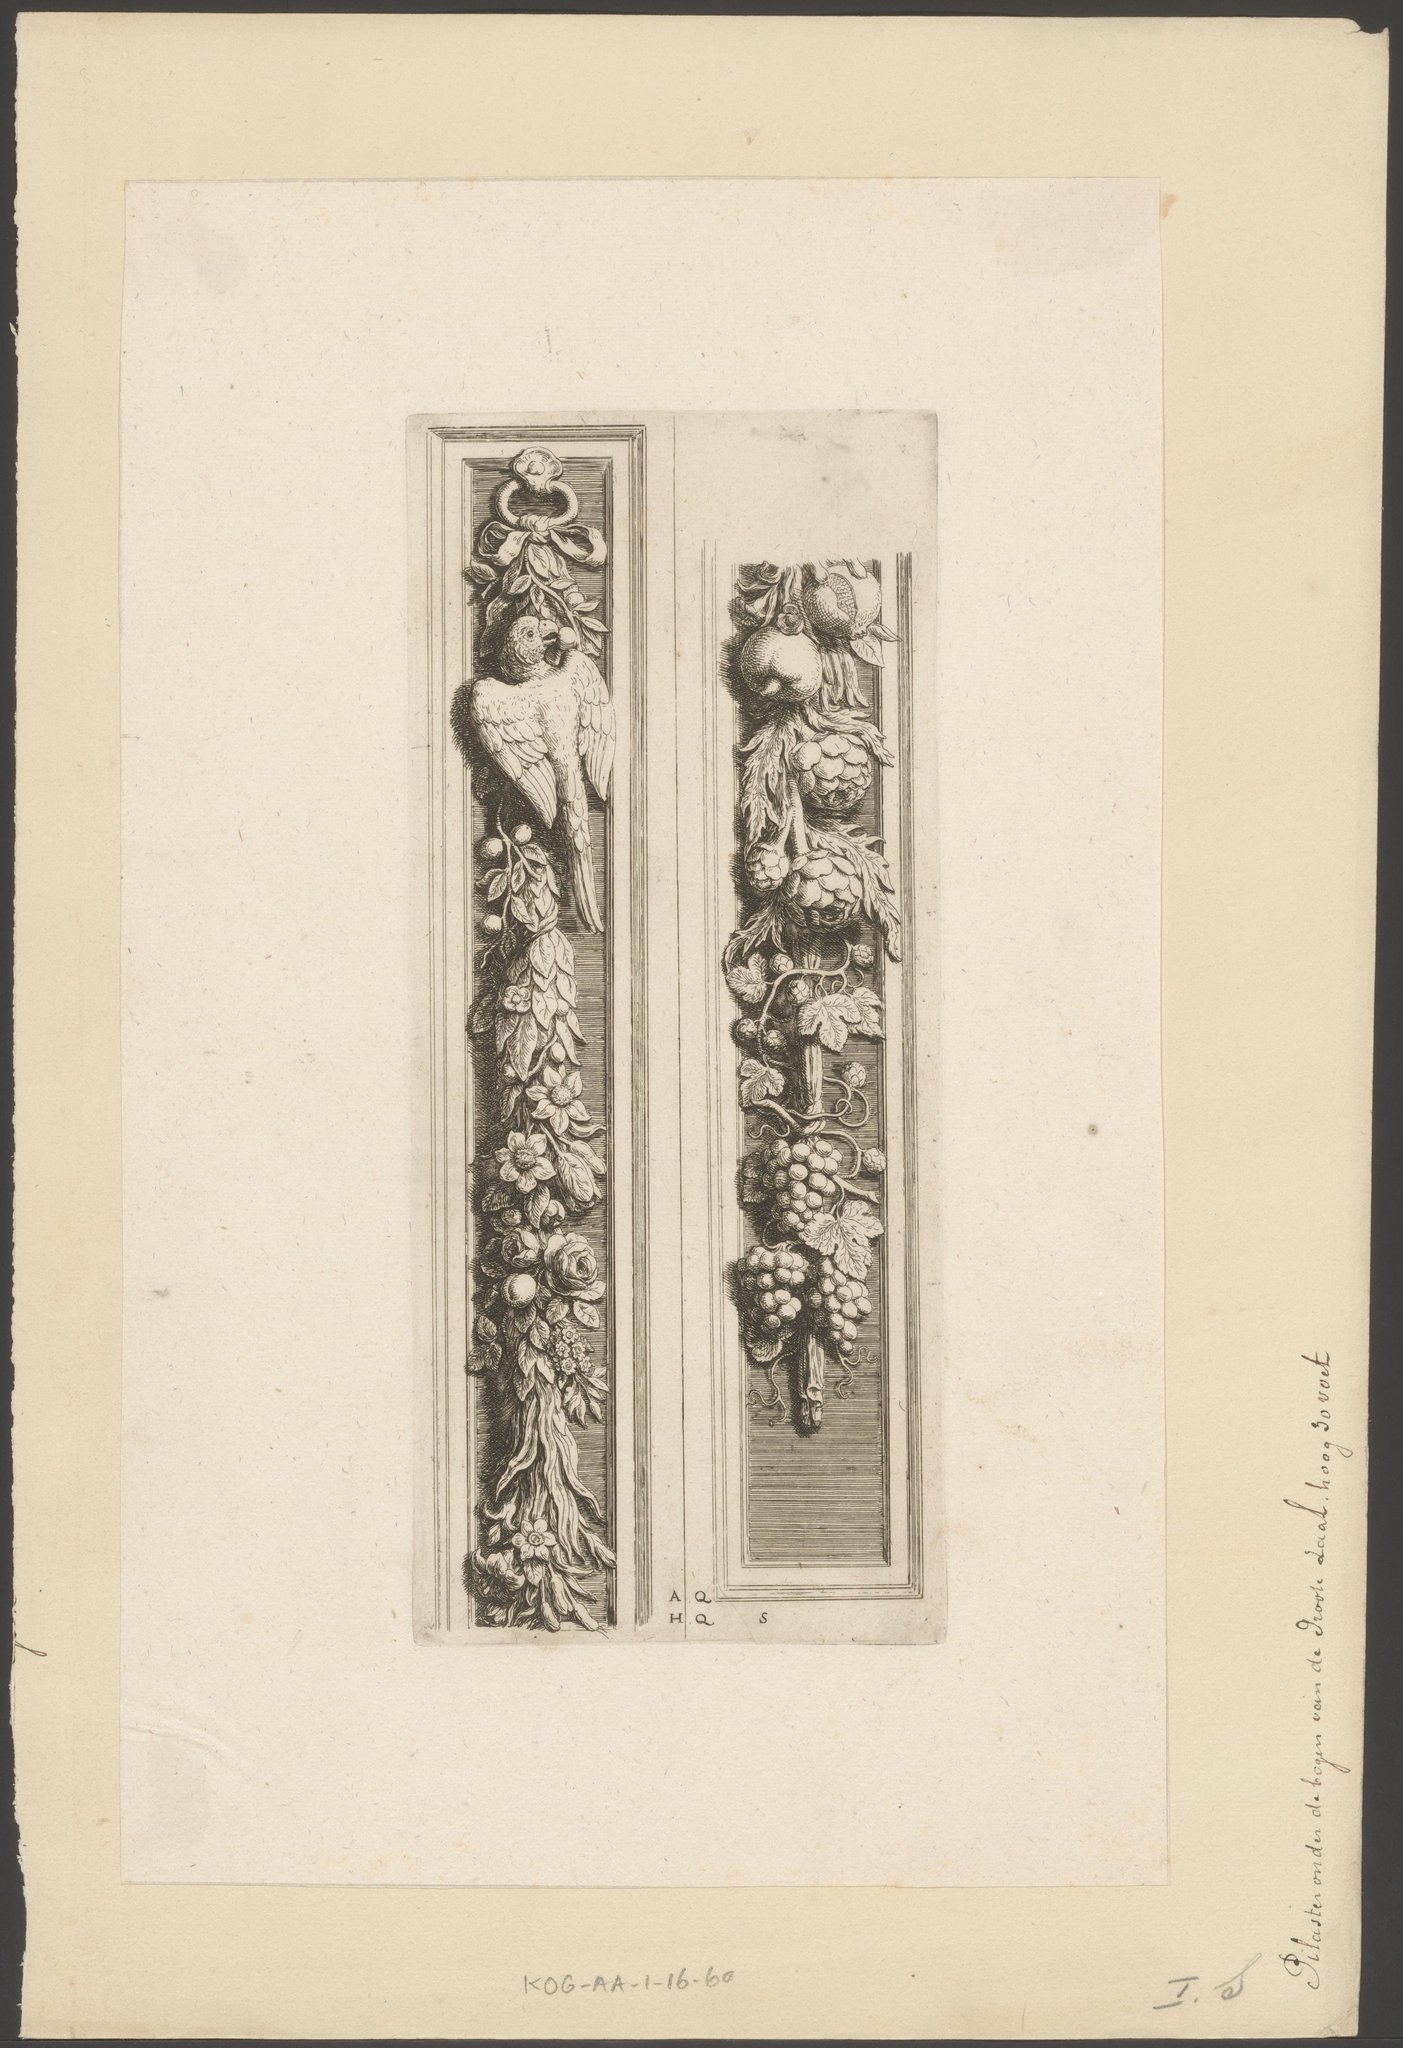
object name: print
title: Pilasterfestoen met papegaai, fruit, bloemen en bladeren tussen galerij en Burgerzaal in het Stadhuis op de Dam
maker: hubert quellinus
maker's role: print maker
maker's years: 1619-1687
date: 1655-1665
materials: paper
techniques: engraving, etching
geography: amsterdam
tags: fruits and vegetables ~ ornament, ornamental birds: parrot, townhall, ornament ~ festoon, garland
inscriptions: collector's mark: ‘16,60’ Lugt 1641b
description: Prent gebruikt in: Prima pars. Praecipuarum effigierum ac ornamentorum, amplissimae Curiae Amstelrodamensis (…) / Het eerste deel. Van de voornaemste Statuen ende Ciraten, vant konstijck Stadhuys van Amstelredam, tmeeste in marmer gemaeckt, door Artus Quellinus, Beelthouwer der voorseyde Stadt / La Premier Partie. De plusieurs Figures et ornements, de la Maison de Ville d'Amsterdam (…). Amsterdam: Artus Quellinus (I), 1655. Zie RP-P-AO-22-1-1 voor bijhorende titelpagina. Zie RP-P-AO-22-1-2 voor bijhorend register. Zie RP-P-AO-22-1A, RP-P-AO-22-1B, RP-P-AO-22-1C, RP-P-AO-22-1D-1, RP-P-AO-22-1D-2, RP-P-AO-22-1E, RP-P-AO-22-1F, RP-P-AO-22-1G, RP-P-AO-22-1H, RP-P-AO-22-1I, RP-P-AO-22-1K-1, RP-P-AO-22-1K-2, RP-P-AO-22-1K-3, RP-P-AO-22-1K-4, RP-P-AO-22-1K-5, RP-P-AO-22-1L-1, RP-P-AO-22-1L-2, RP-P-AO-22-1M-1, RP-P-AO-22-1M-2, RP-P-AO-22-1N-1, RP-P-AO-22-1N-2, RP-P-AO-22-1N-3, RP-P-AO-22-1N-4, RP-P-AO-22-1N-5, RP-P-AO-22-1O-1, RP-P-AO-22-1O-2, RP-P-AO-22-1O-3, RP-P-AO-22-1O-4, RP-P-AO-22-1P-1, RP-P-AO-22-1P-2, RP-P-AO-22-1P-3, RP-P-AO-22-1P-4, RP-P-AO-22-1Q-1, RP-P-AO-22-1Q-2, RP-P-AO-22-1Q-3, RP-P-AO-22-1Q-4, RP-P-AO-22-1R-1, RP-P-AO-22-1R-2, RP-P-AO-22-1R-3, RP-P-AO-22-1R-4, RP-P-AO-22-1R-5, RP-P-AO-22-1S-2, RP-P-AO-22-1S-3, RP-P-AO-22-1S-4, RP-P-AO-22-1S-5, RP-P-AO-22-1T-1 en RP-P-AO-22-1T-2 voor andere prenten uit deze publicatie. Zelfde staat van prent ook gebruikt in: Prima pars. Praecipuarum effigierum ac ornamentorum, amplissimae Curiae Amstelrodamensis (…) / Het eerste deel. Van de voornaemste Statuen ende Ciraten, vant konstijck Stadhuys van Amstelredam, tmeeste in marmer gemaeckt, door Artus Quellinus, Beelthouwer der voorseyde Stadt / La Premier Partie. De plusieurs Figures et ornements, de la Maison de Ville d'Amsterdam (…). Amsterdam: Frederik de Wit, 1665. Latere staat van prent ook gebruikt in: Architecture peinture et sculpture de la Maison de Ville d'Amsterdam, representee en CIX. figures en taille-douce (…). Amsterdam: David Mortier, 1719. En in: Architecture peinture et sculpture de la Maison de Ville d'Amsterdam, representee en CIX. figures en taille-douce (…). Amsterdam: Gerard Valck, 1719. En in: Bouw schilder en beeldhouwkonst, van het Stadhuis te Amsteldam, vertoont in CIX figuuren (…). Amsterdam: Covens & Mortier & Covens Jr., s.a. (1774-1783).